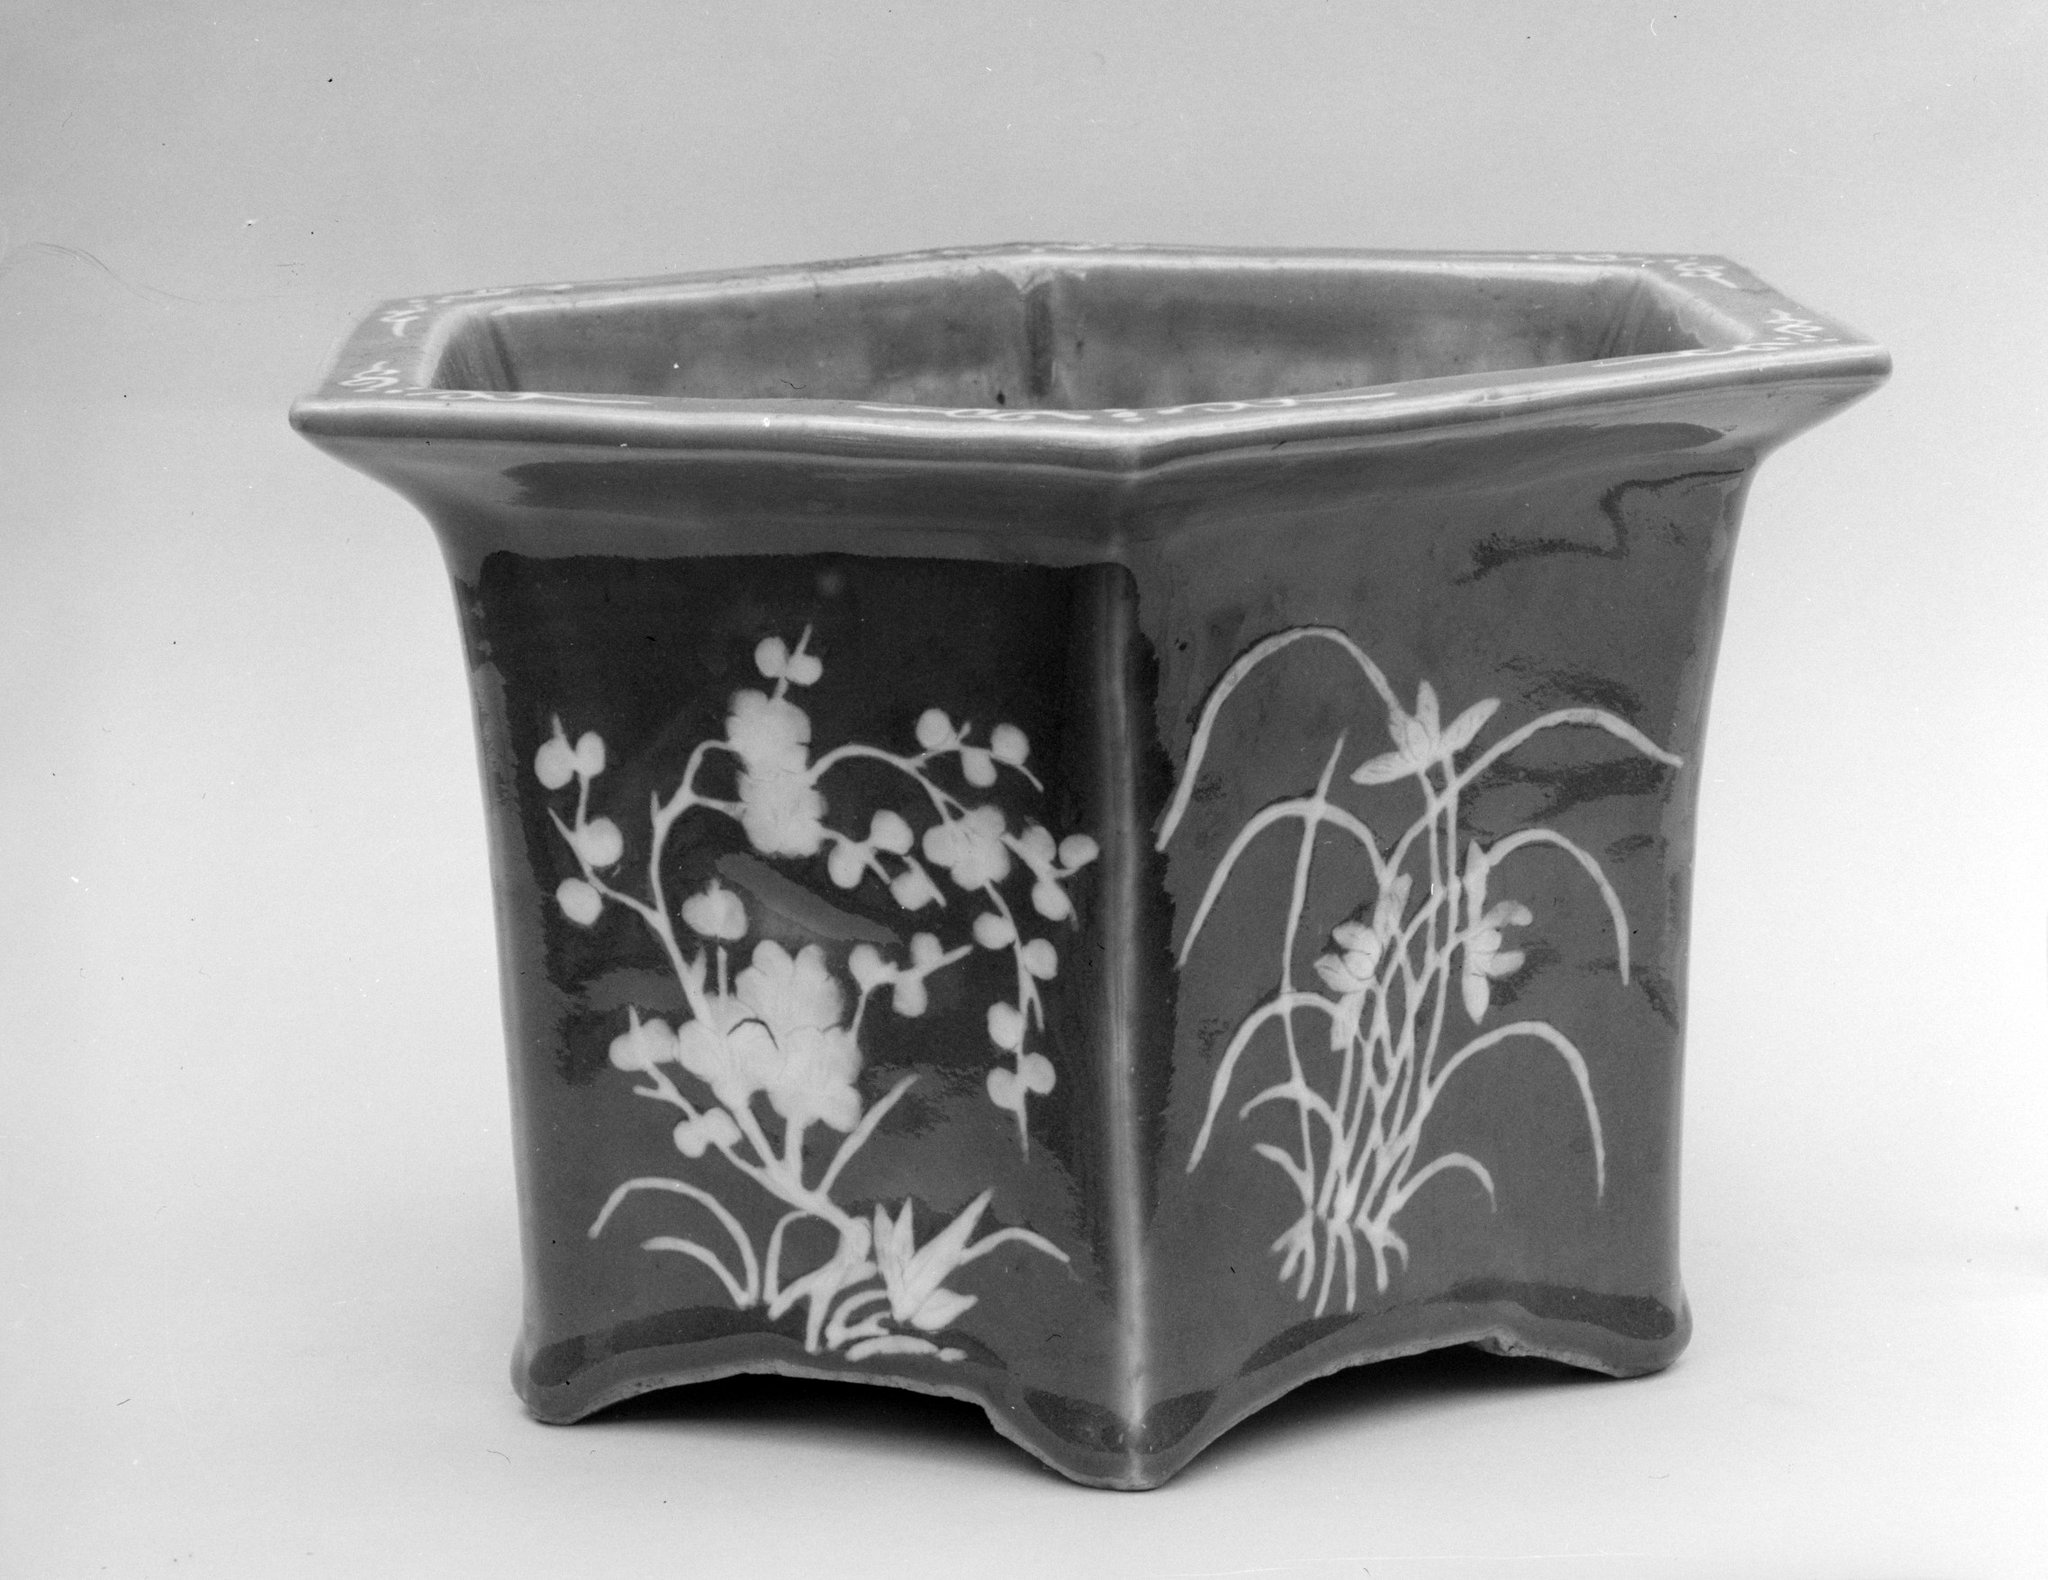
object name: jardinière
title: Jardiniere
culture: chinese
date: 1700-1800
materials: porcelain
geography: china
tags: flowers